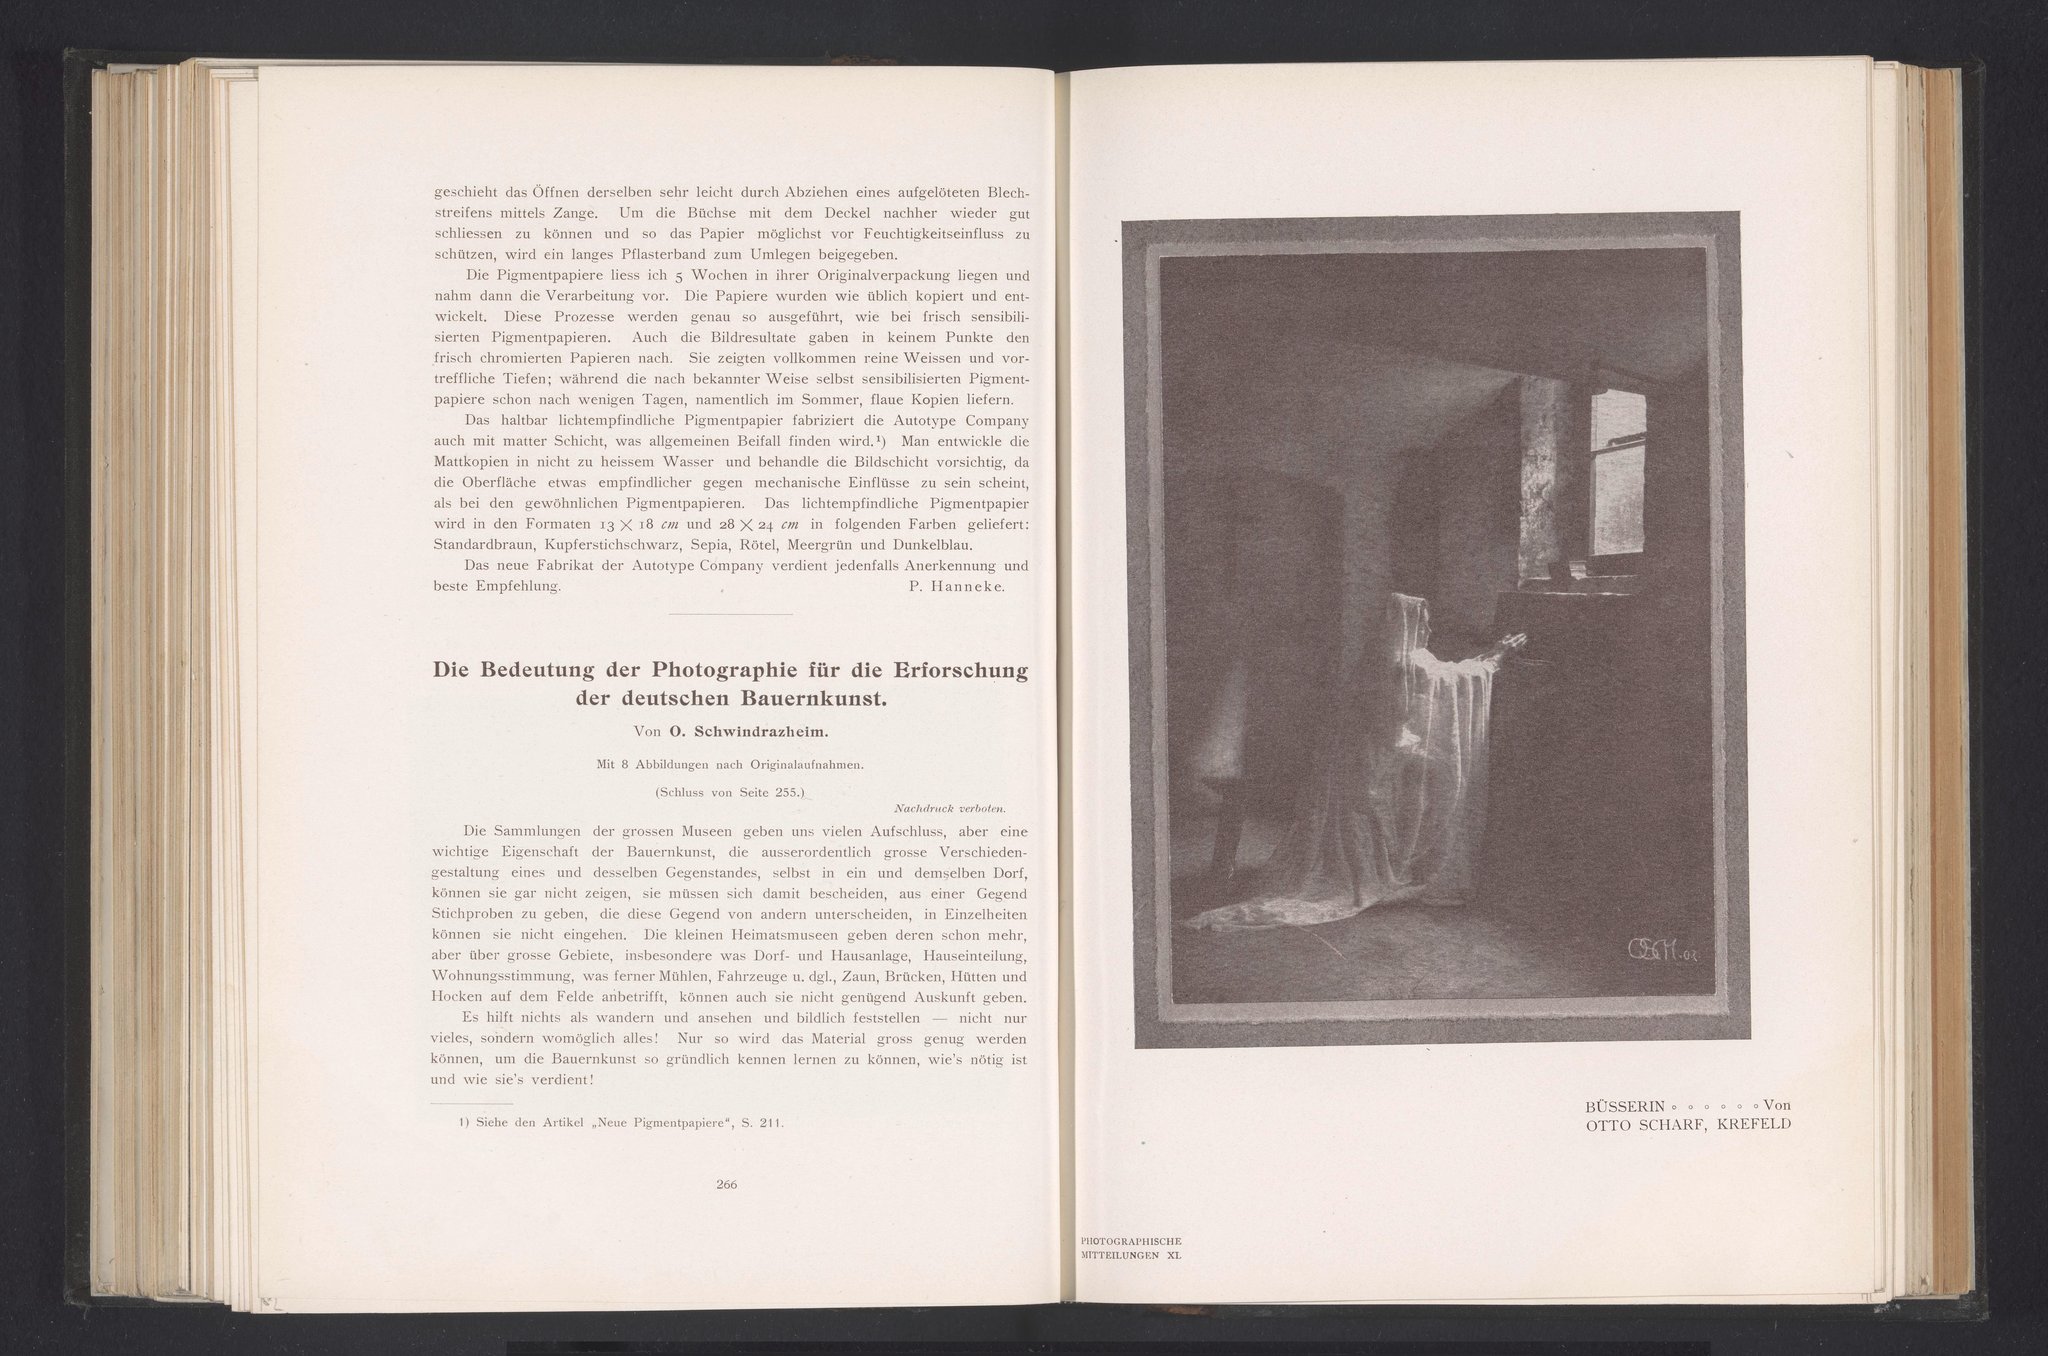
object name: page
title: Portret van een onbekende vrouw verbeeld als boeteling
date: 1898-1903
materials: paper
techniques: autotype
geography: krefeld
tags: historical persons - bb - woman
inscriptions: inscription: ‘Photographische Mitteilungen XL’